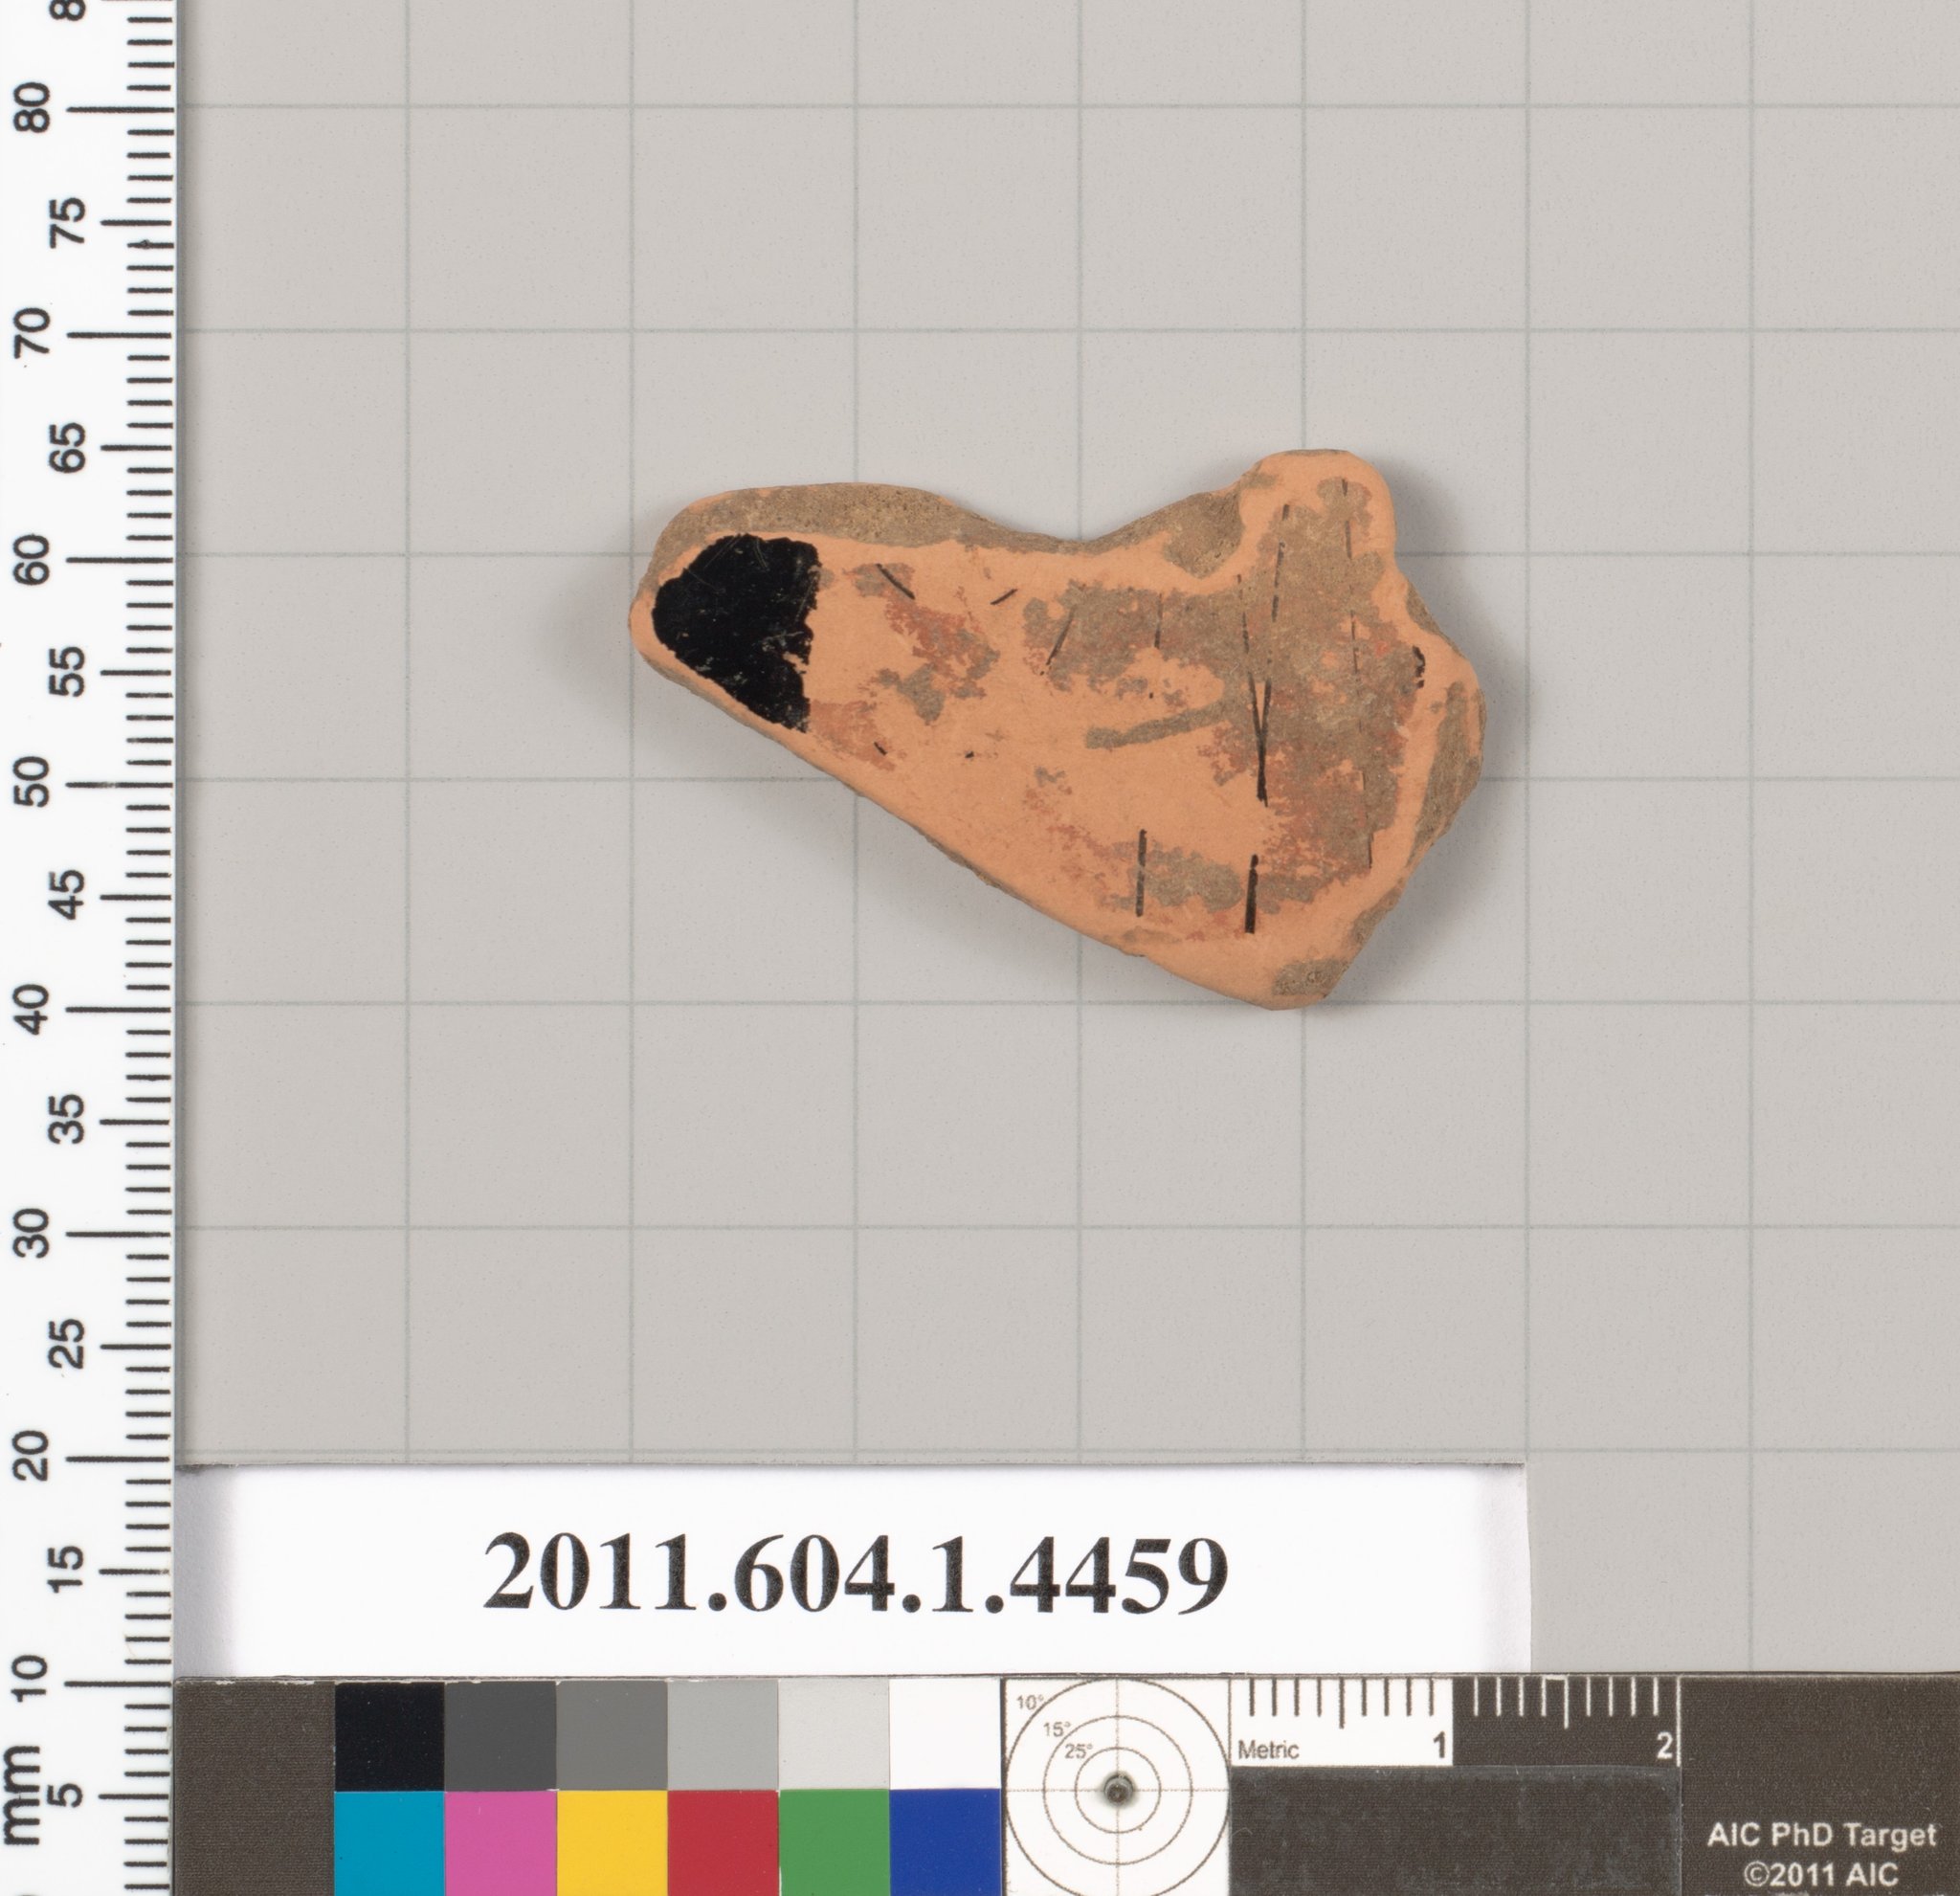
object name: kylix fragment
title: Terracotta fragment of a kylix (drinking cup)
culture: greek, attic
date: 500-451 BCE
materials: terracotta